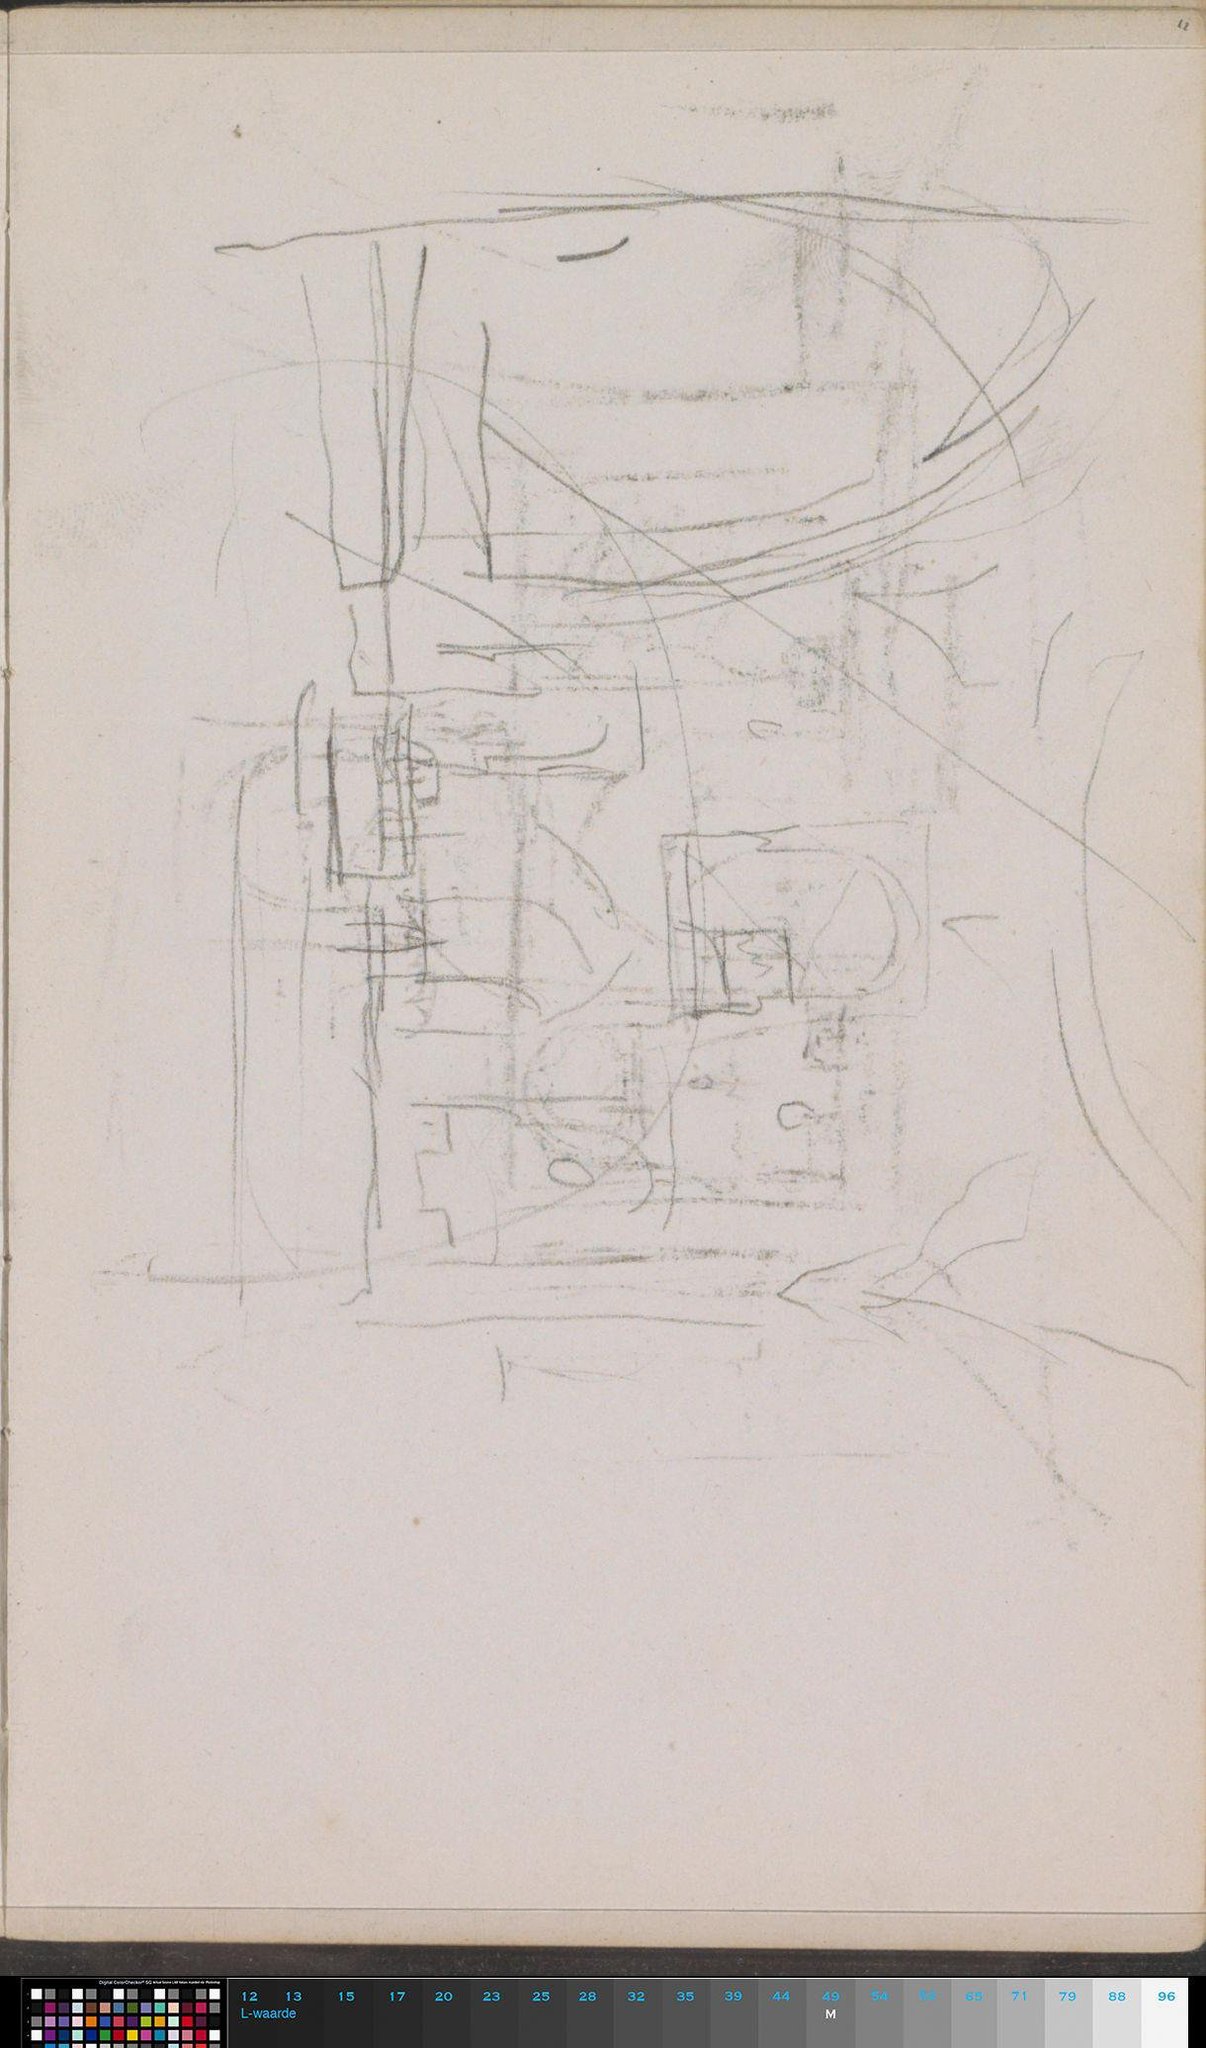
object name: sketchbook leaf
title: Interieur, mogelijk van een moskee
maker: marius bauer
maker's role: draughtsman, print maker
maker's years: 1867-1932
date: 1896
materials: chalk, paper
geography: istanbul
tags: temple, shrine ~ islam, mohammedanism, architecture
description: Pagina 11 uit een schetsboek met 53 bladen.